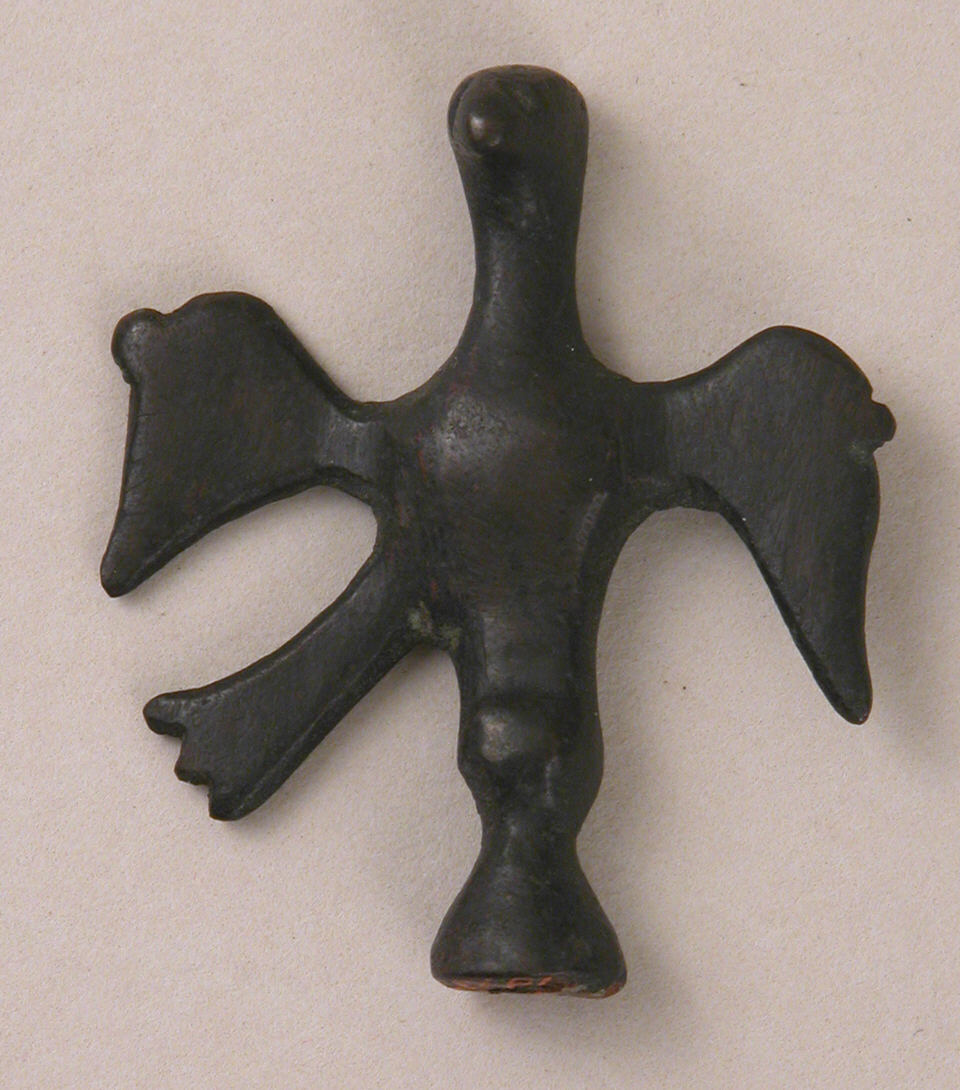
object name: finial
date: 901-1200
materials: bronze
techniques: casting, hammering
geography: egypt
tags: birds